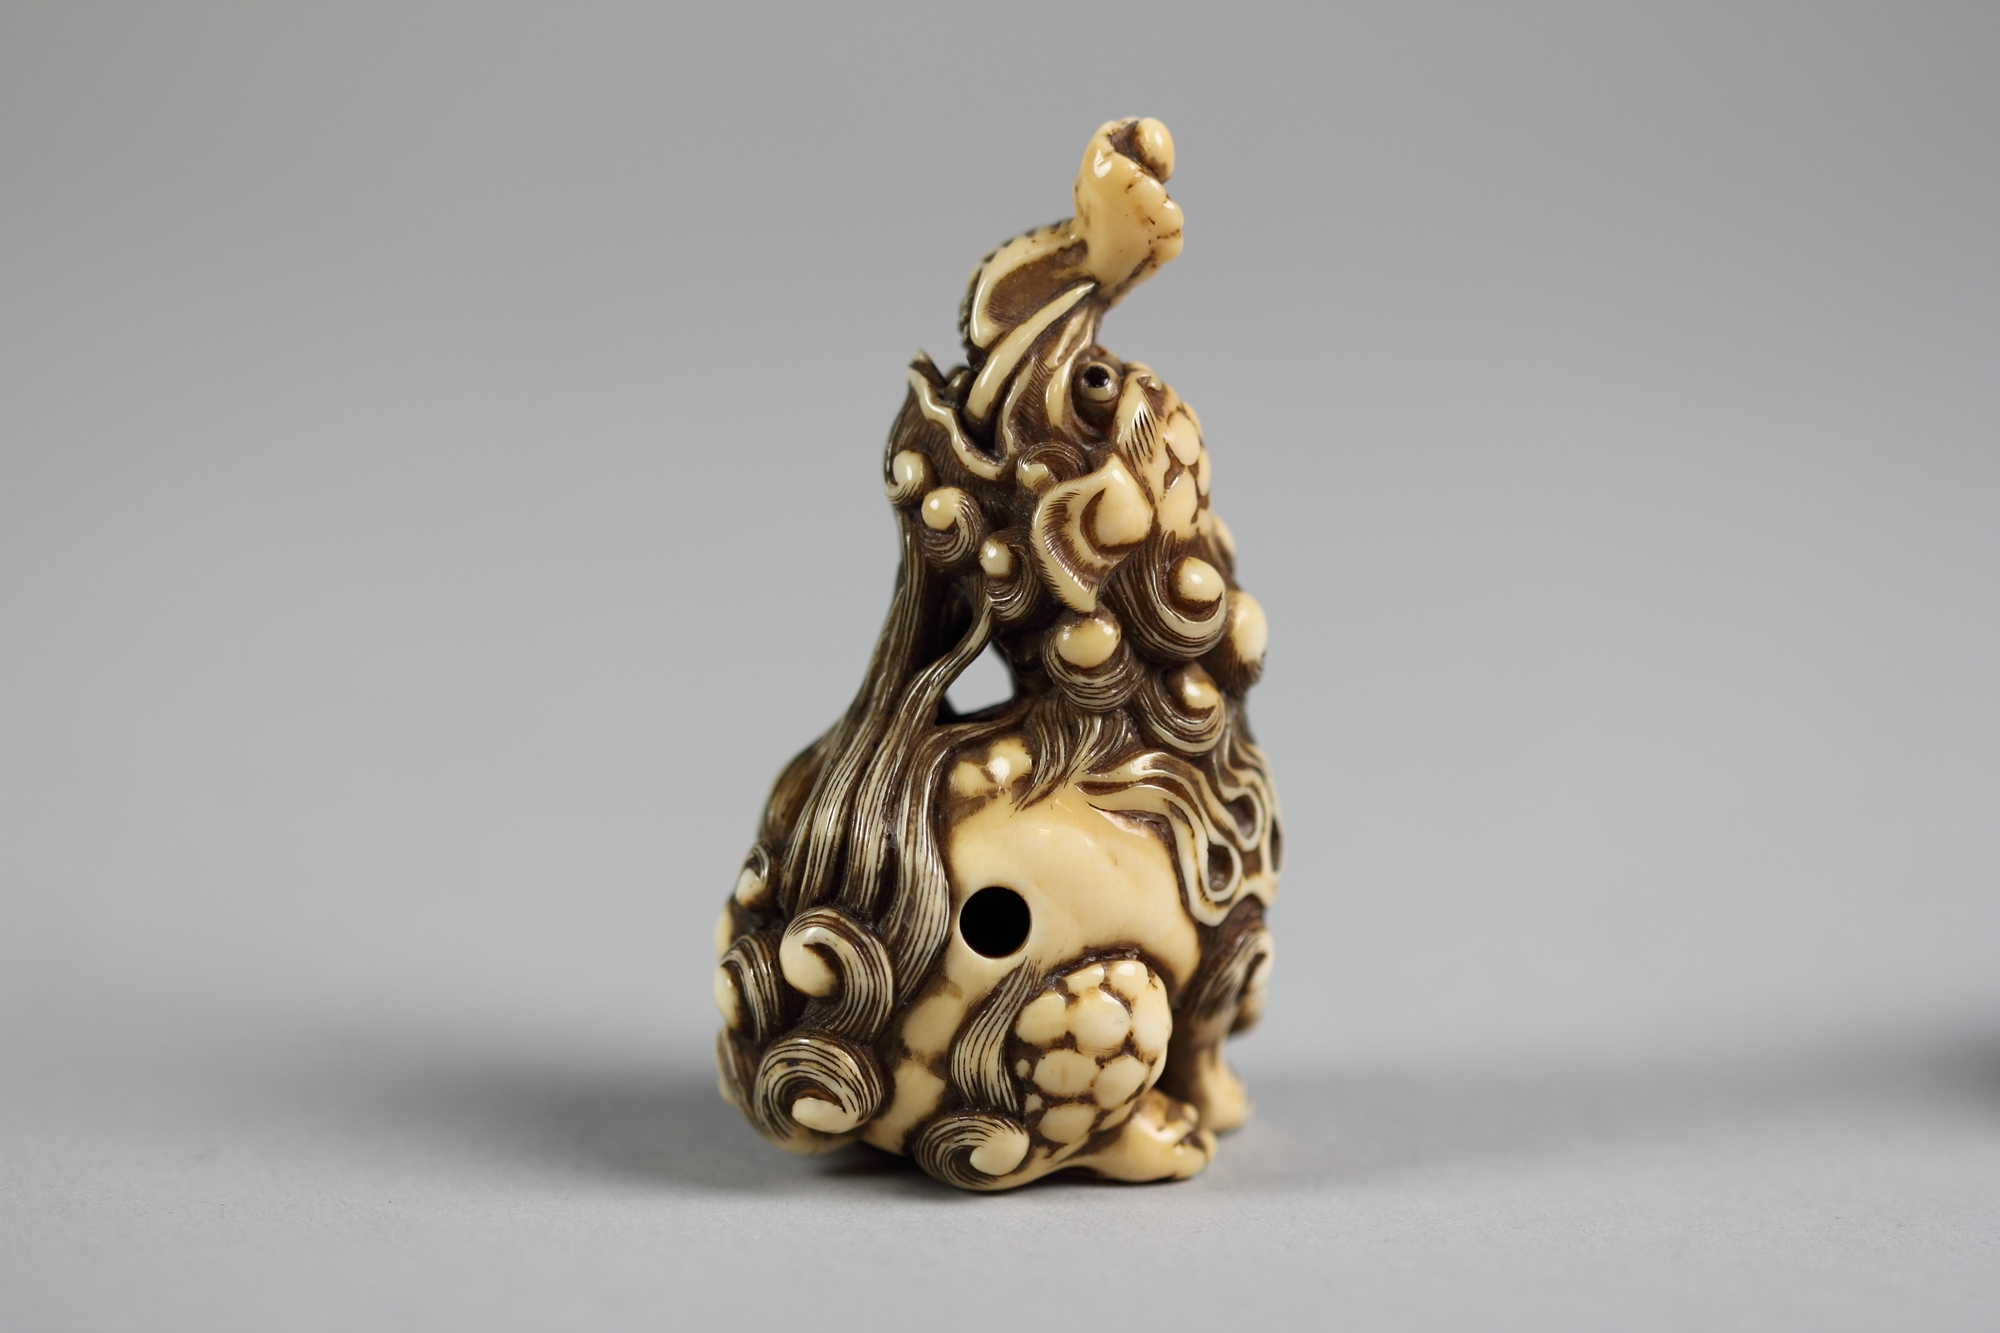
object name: netsuke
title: Seated Baku (Mythical Creature Devouring Nightmares)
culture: japanese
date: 1701-1800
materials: ivory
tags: mythical creatures